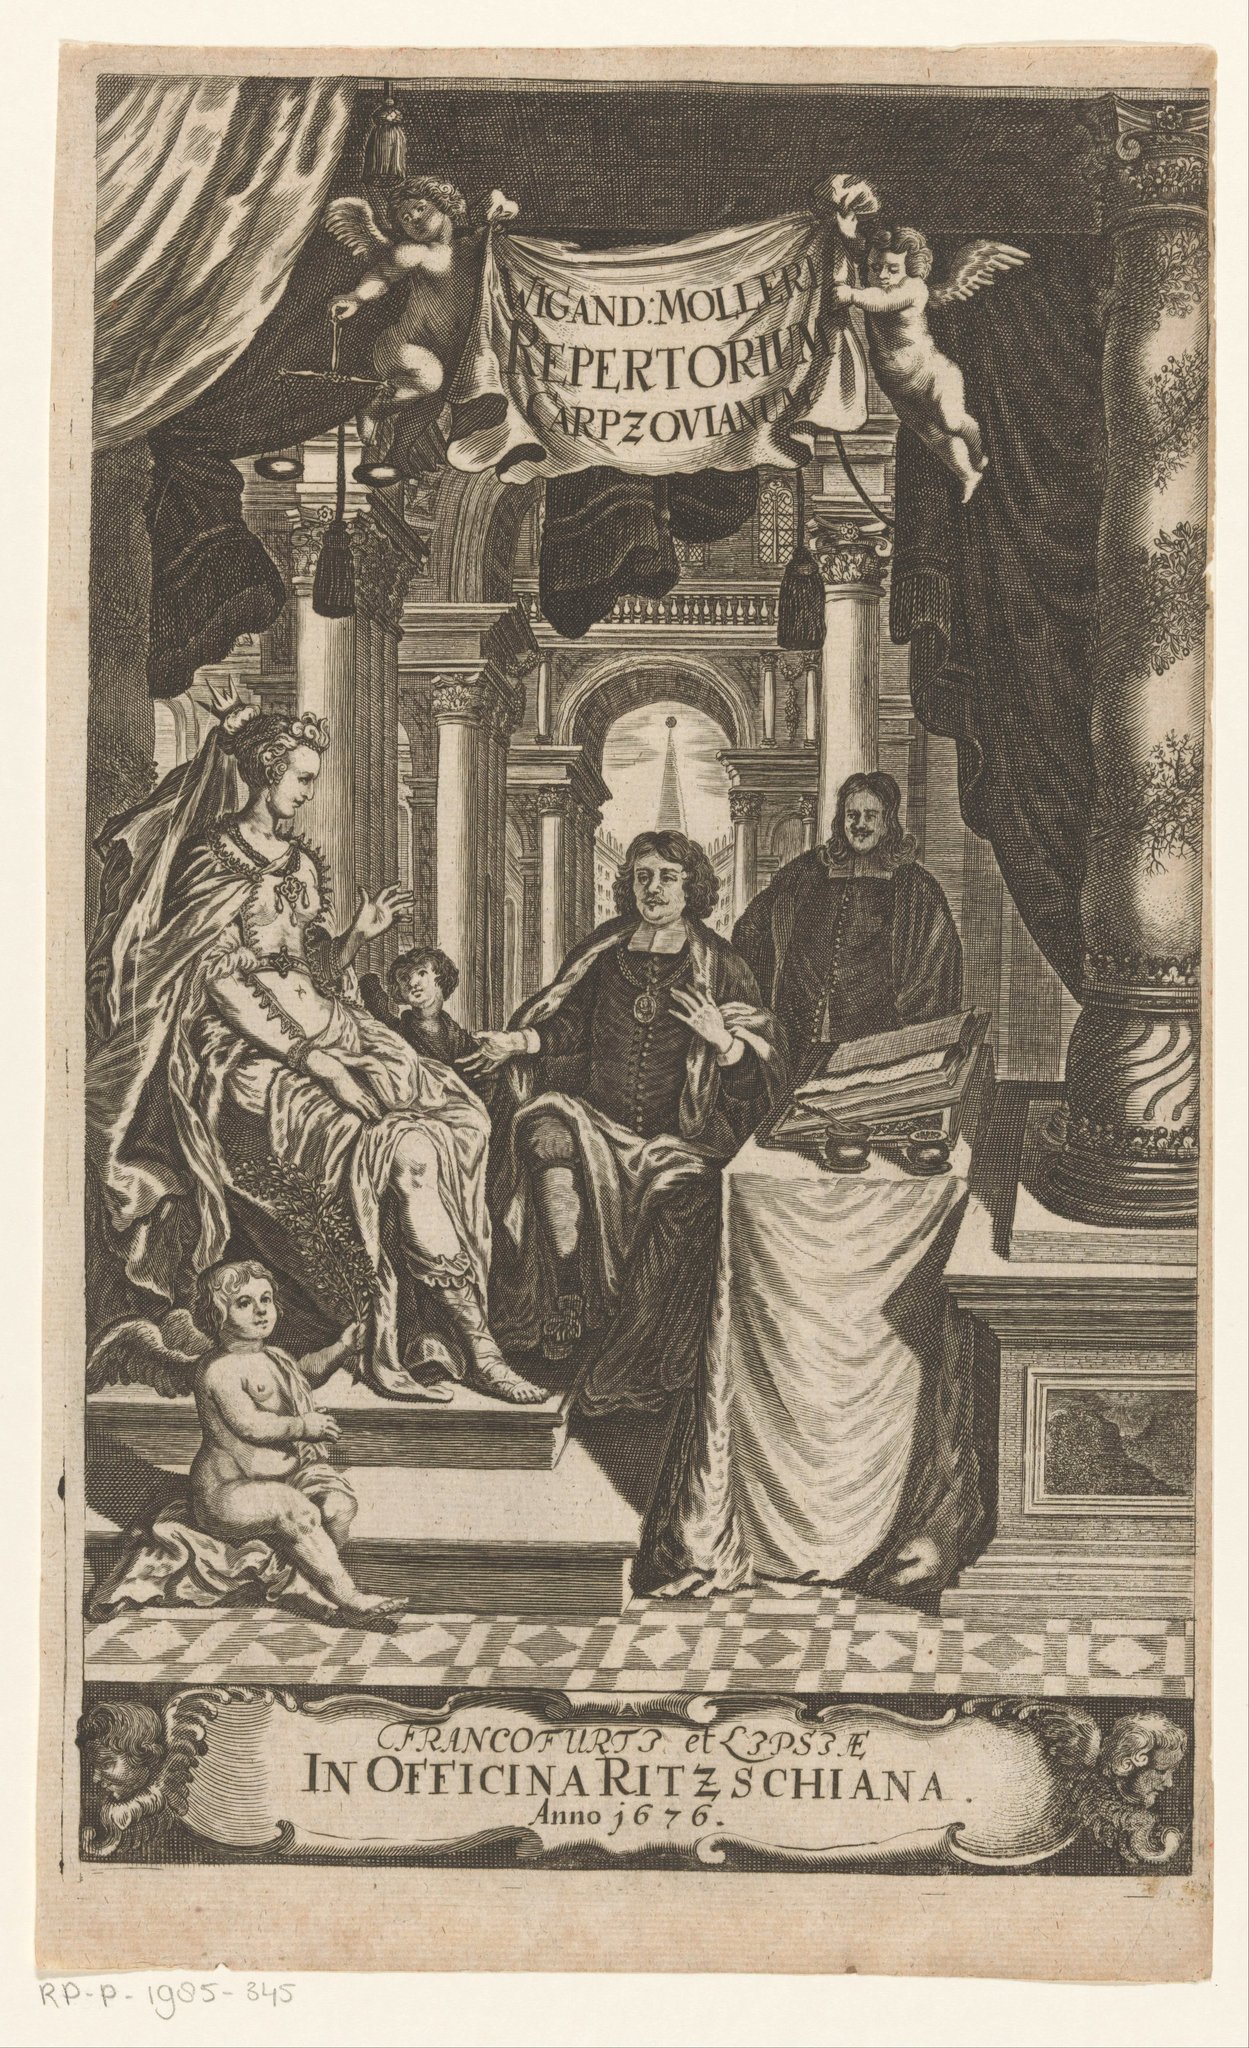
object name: print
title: Titelpagina voor: Wigand Möller, Repertorium rerum, verborum, et notabilium, 1676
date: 1676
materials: paper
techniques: engraving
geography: frankfurt am main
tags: queen, lawyer, attorney at law, book - mm - book open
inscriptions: inscription: ‘28-11-85 / 1+2’, collector's mark: Lugt 2228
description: Jurist Benedikt Carpzov staat naast een koningin zittend op een troon. Beiden tonen hun rechteronderbeen onder hun kleding. Rechts staat een open boek op een lessenaar. Links op de voorgrond zit een putto met een tak. Aan de bovenzijde vliegen twee putti met een weegschaal en draperie met titel.